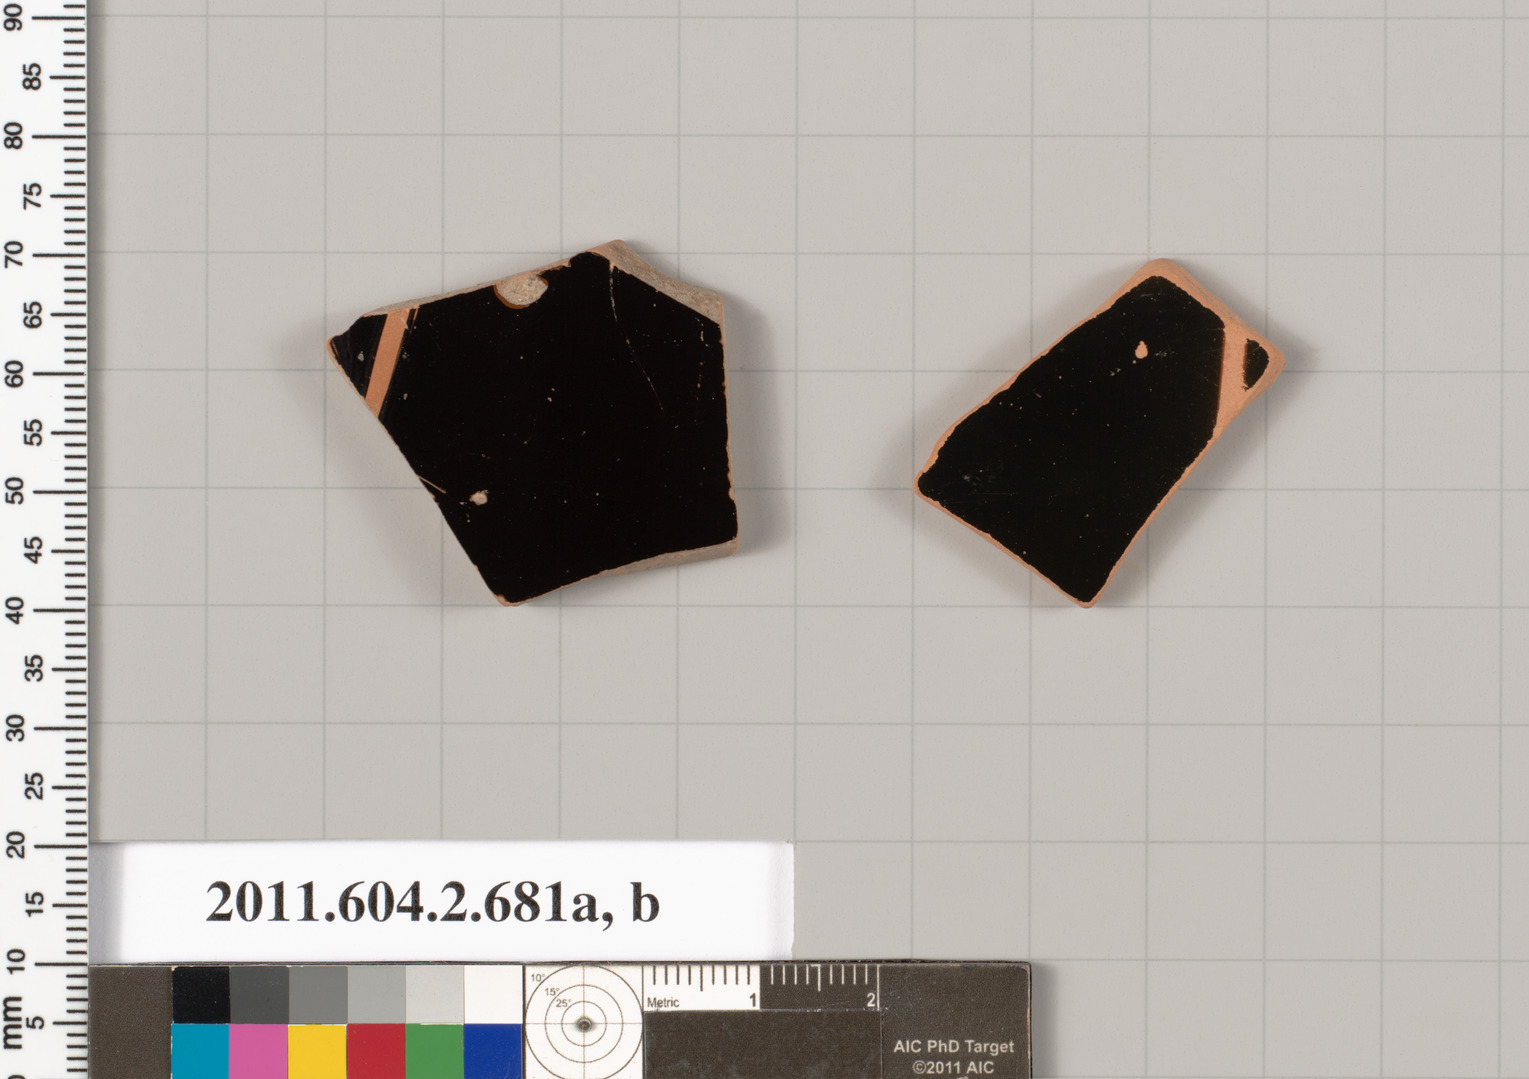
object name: column krater fragment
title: Terracotta fragments of column-kraters (bowls for mixing wine and water)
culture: greek, attic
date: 475-440 BCE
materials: terracotta